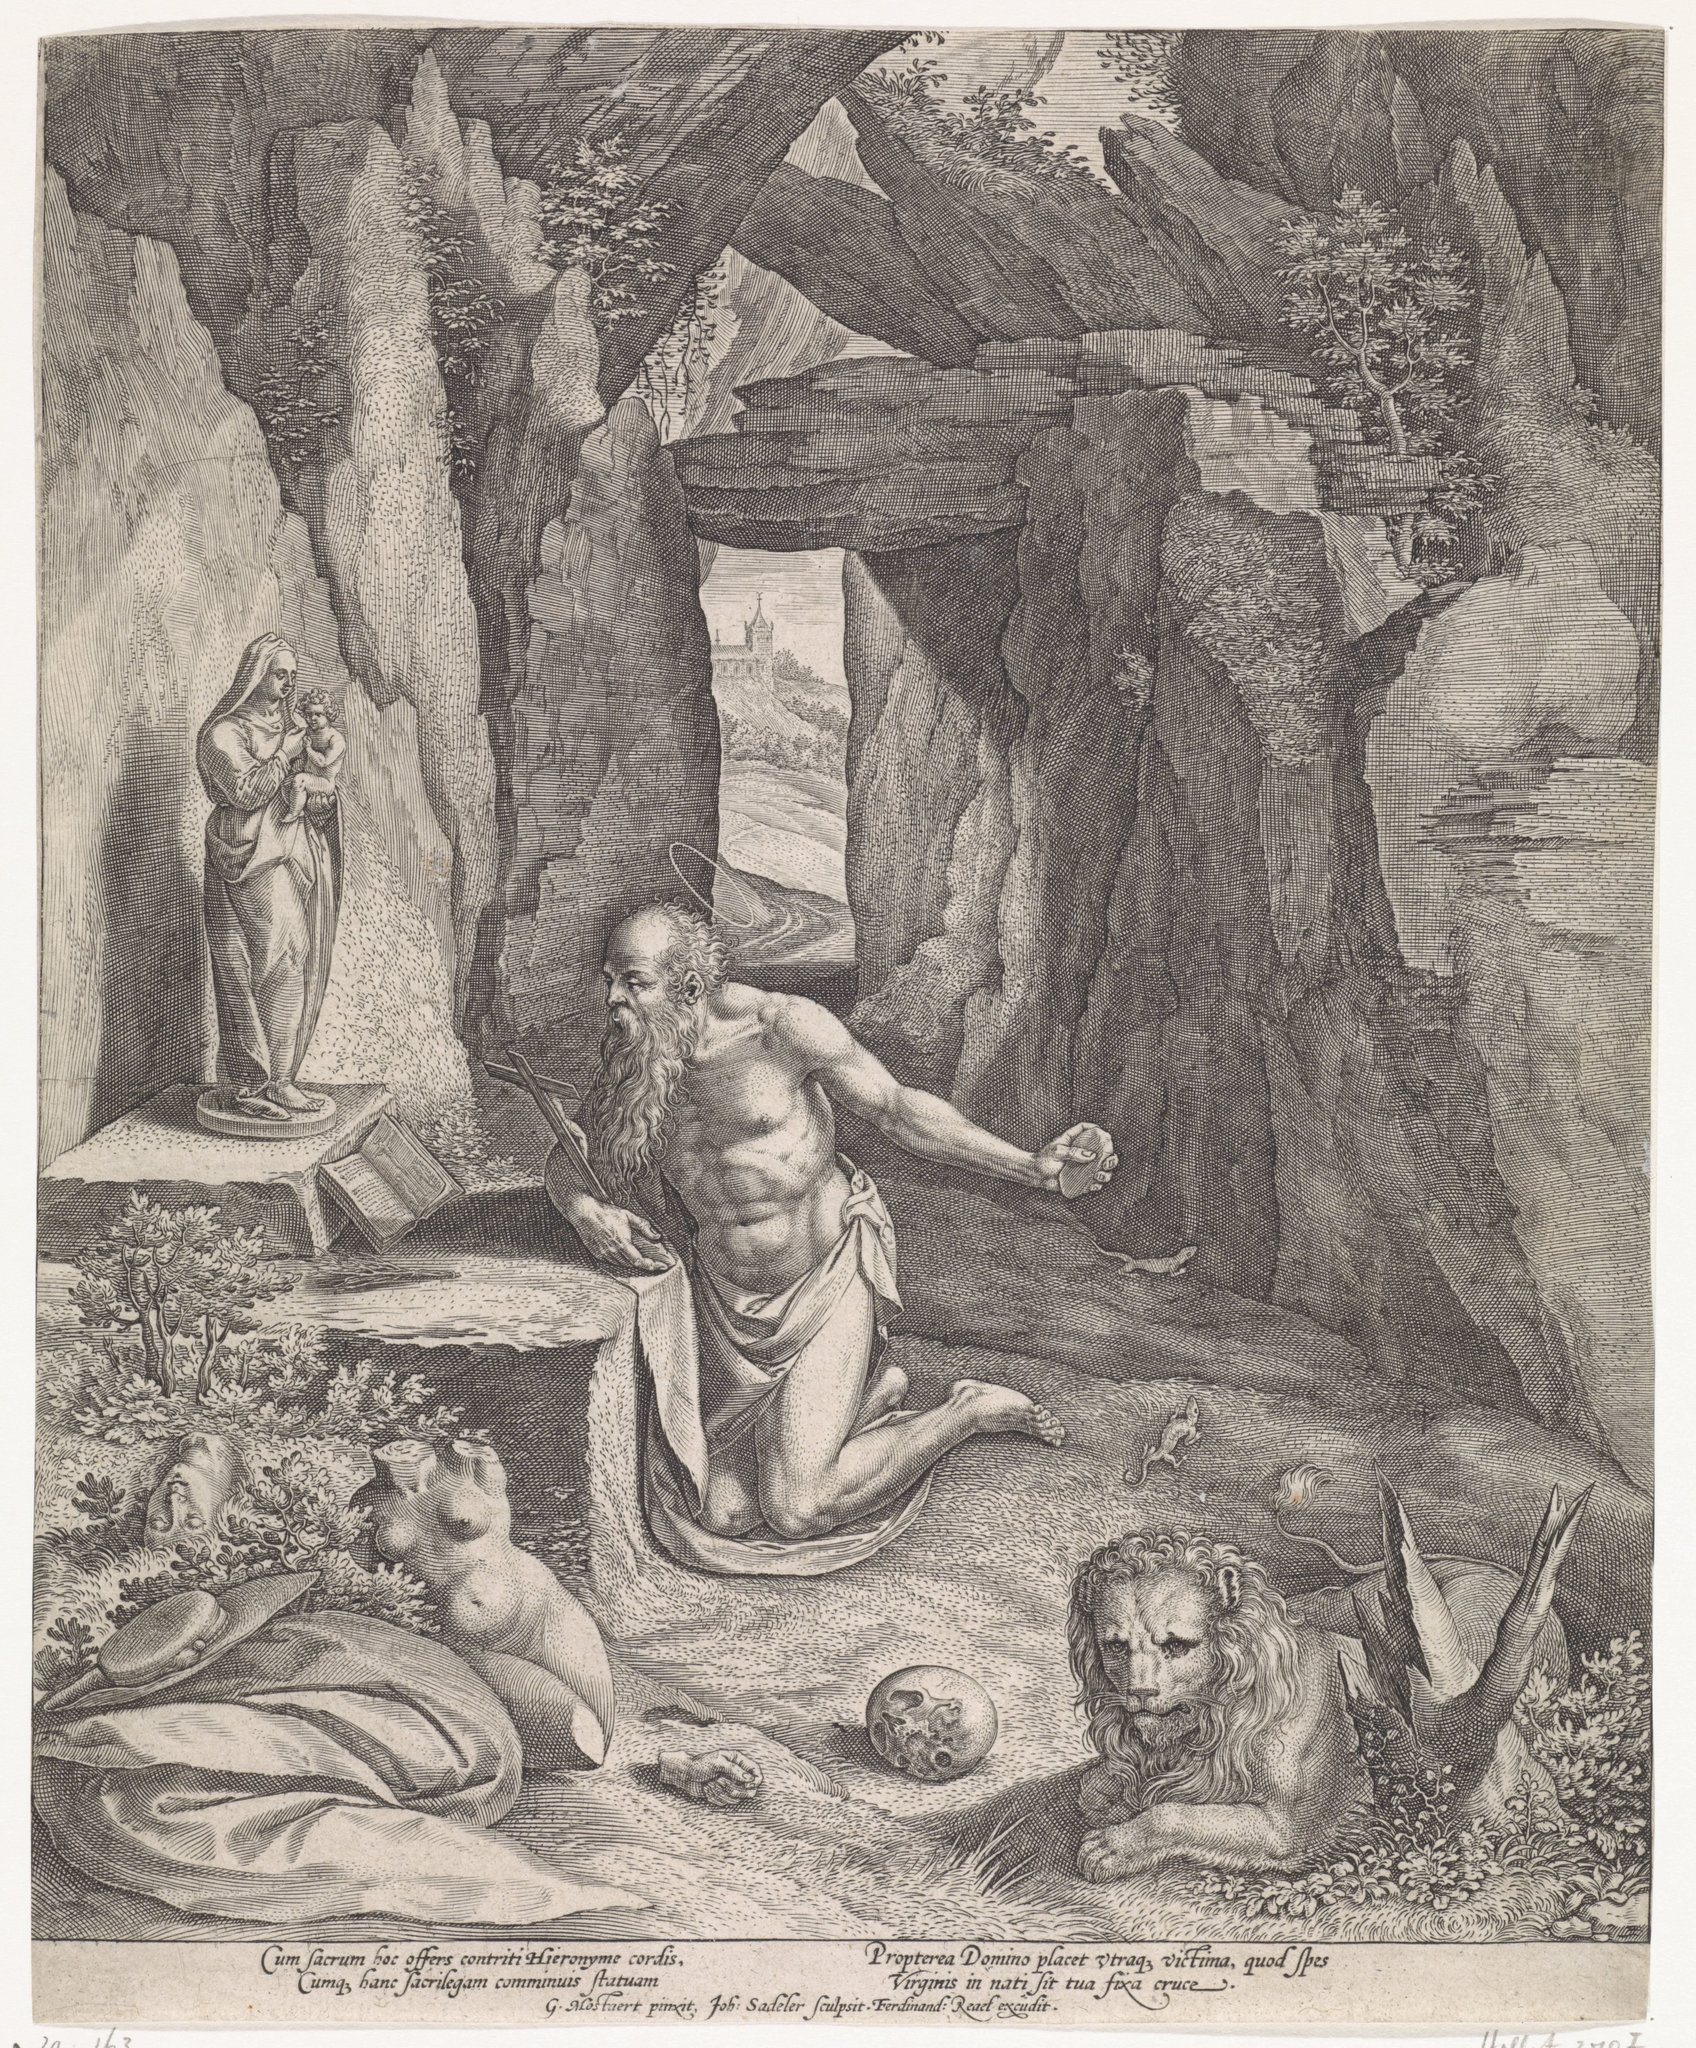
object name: print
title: Heilige Hieronymus in de grot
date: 1560-1593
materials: paper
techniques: engraving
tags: specific aspects ~ st. jerome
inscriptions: collector's mark: Lugt 2228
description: De naakte H. Hieronymus in de grot, knielend naar links. In zijn handen een steen. Voor hem het beeld van de maagd Maria met het Christuskind. Rechts de leeuw. Links zijn kardinaalshoed en een klassiek beeld. De prent heeft een Latijns onderschrift met uitleg.